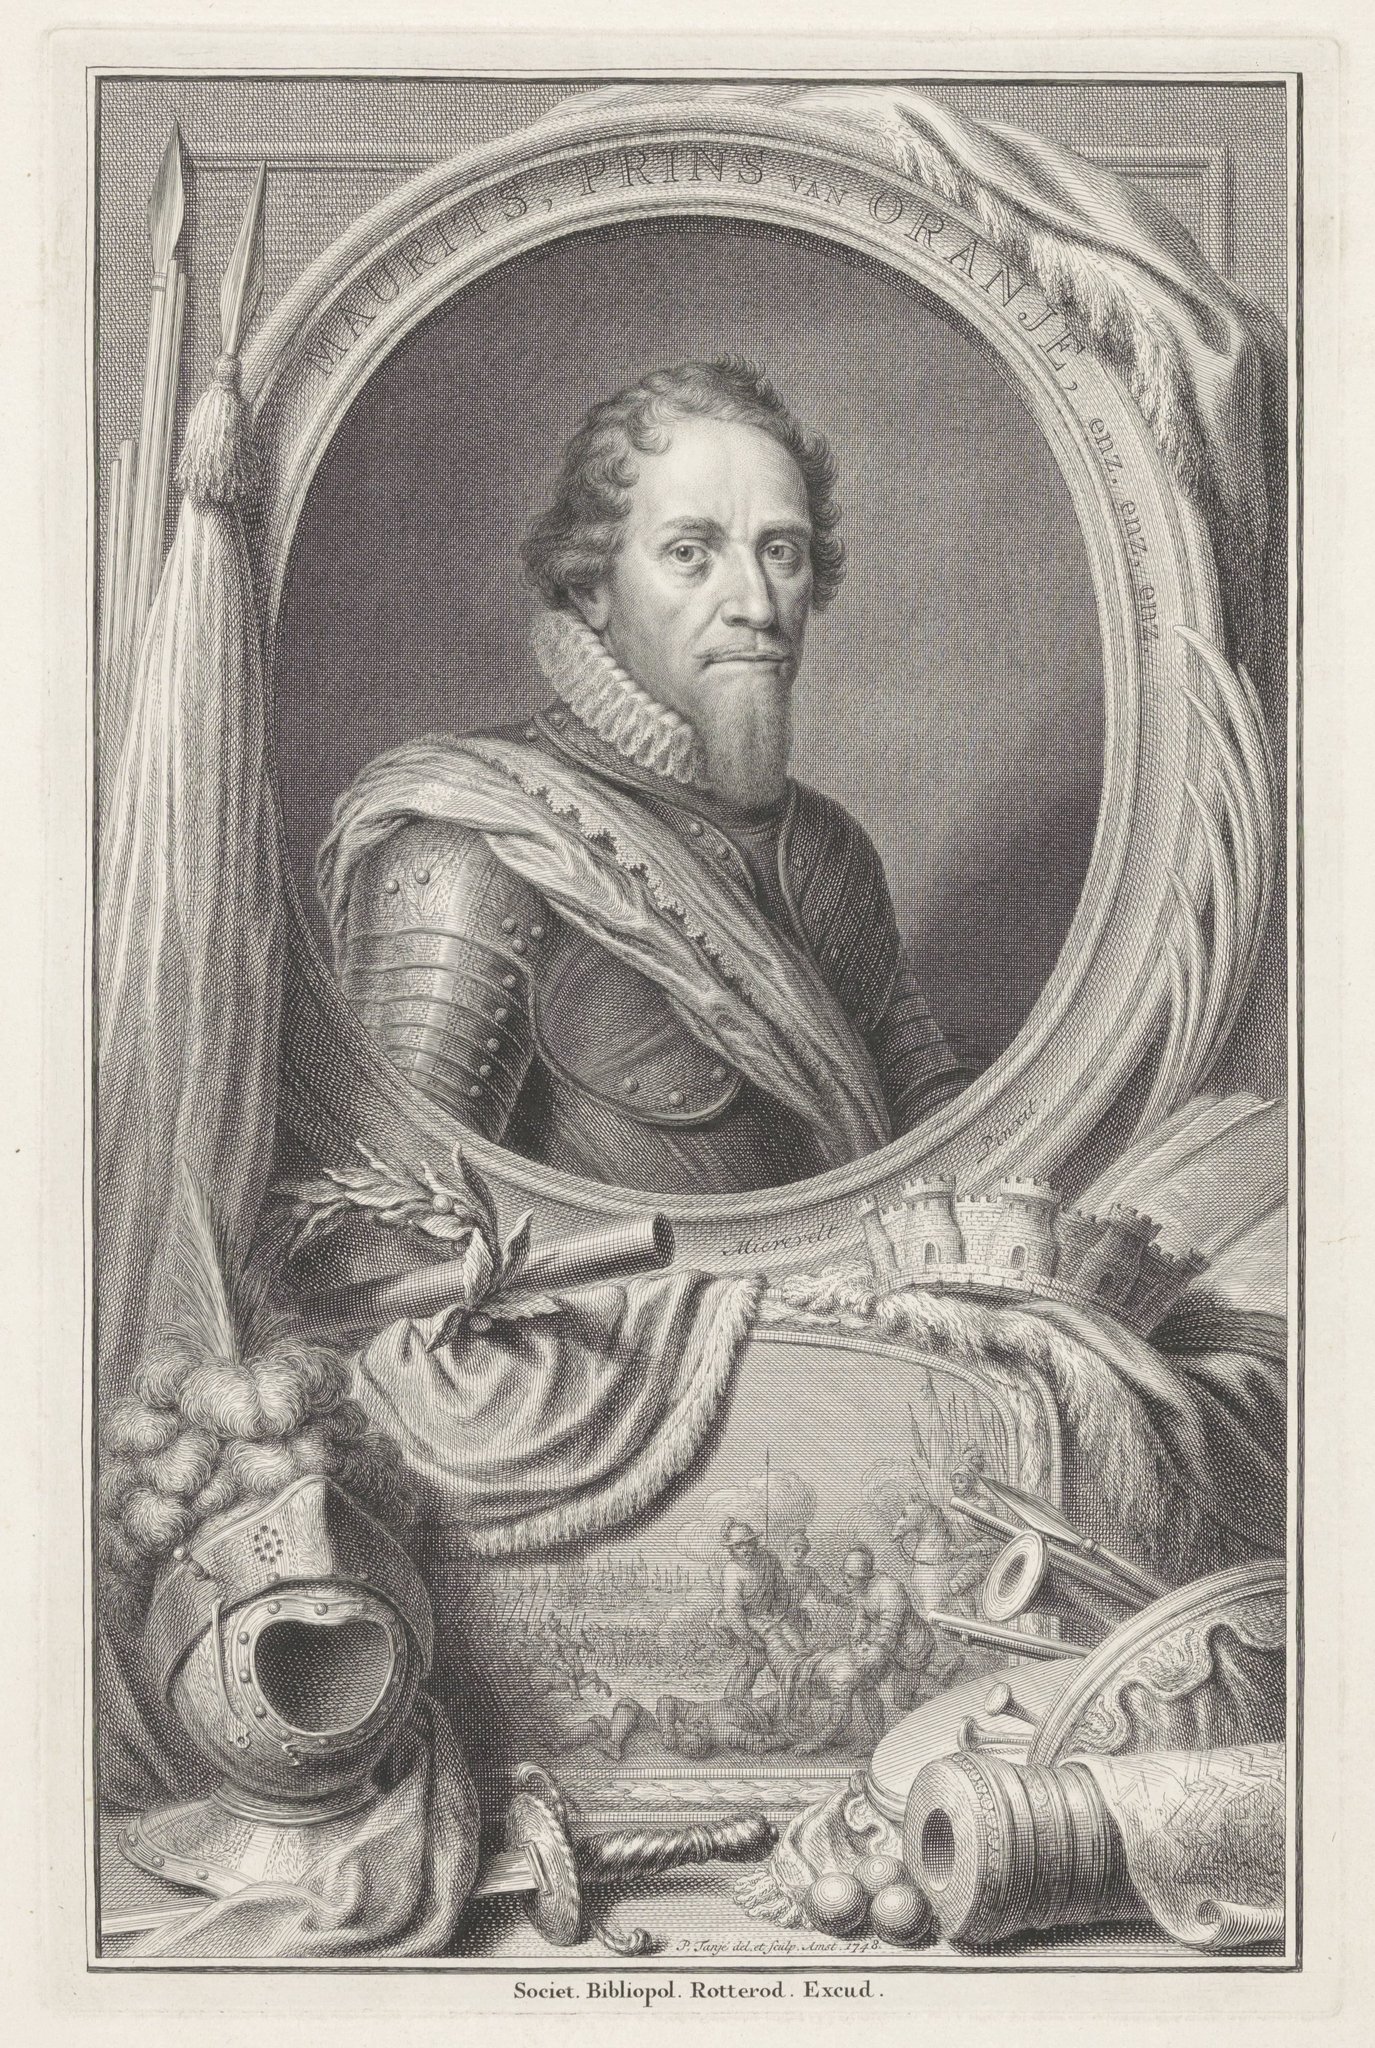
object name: print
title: Portret van Maurits, prins van Oranje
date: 1748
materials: paper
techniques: engraving, etching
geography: amsterdam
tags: the hague, maurice (prince of orange), city-crown, mural crown, helmet, hacking and thrusting weapons: sword, battle of nieuwpoort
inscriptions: date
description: Portret van Maurits in een ovaal met randschrift. Rondom ligt een aantal allegorische objecten, waaronder een scepter, lauwerkrans, muurkroon, helm, zwaard en kanon. Op het reliëf de Slag bij Nieuwpoort, 2 juli 1600.